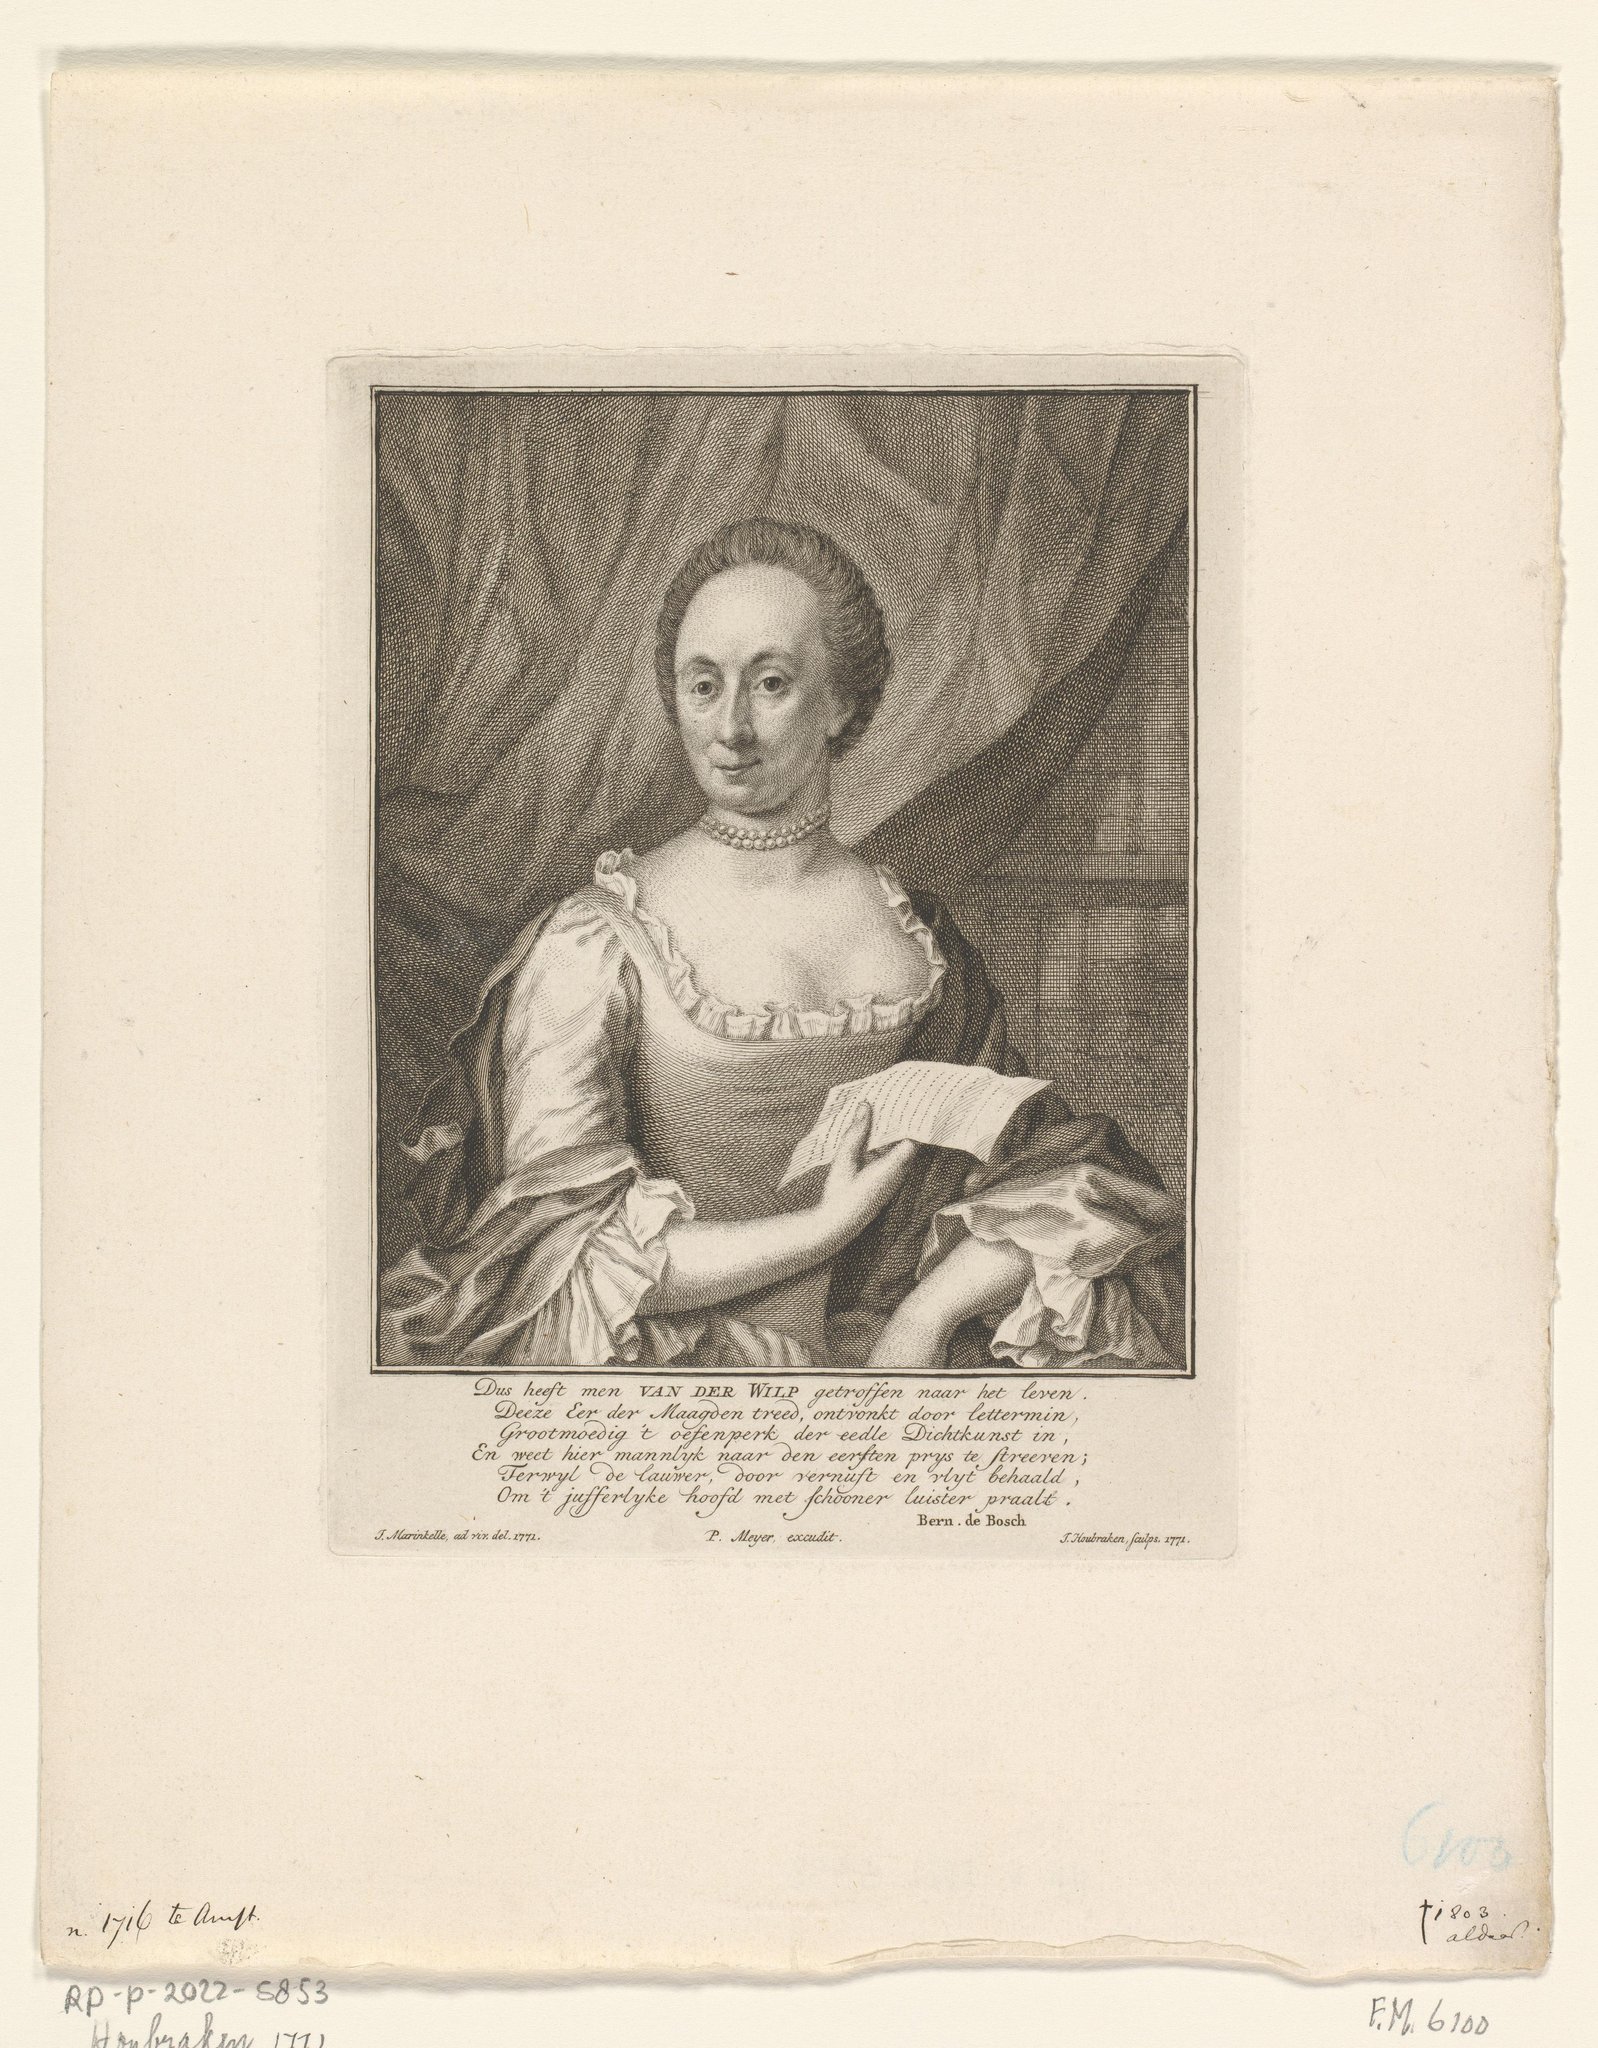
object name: print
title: Portret van Sara Maria van der Wilp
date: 1771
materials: paper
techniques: engraving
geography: amsterdam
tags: sara maria van der wilp, historical persons, author, poet writing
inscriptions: collector's mark: Lugt 2228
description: Wilp, Sara Maria van der. Gedichten van Sara Maria van der Wilp. [Oprecht verhaal wegens het portraitteeren van Mejuffrouw Sara Maria van der Wilp (...)] Amsterdam: Pieter Meijer, 1772.